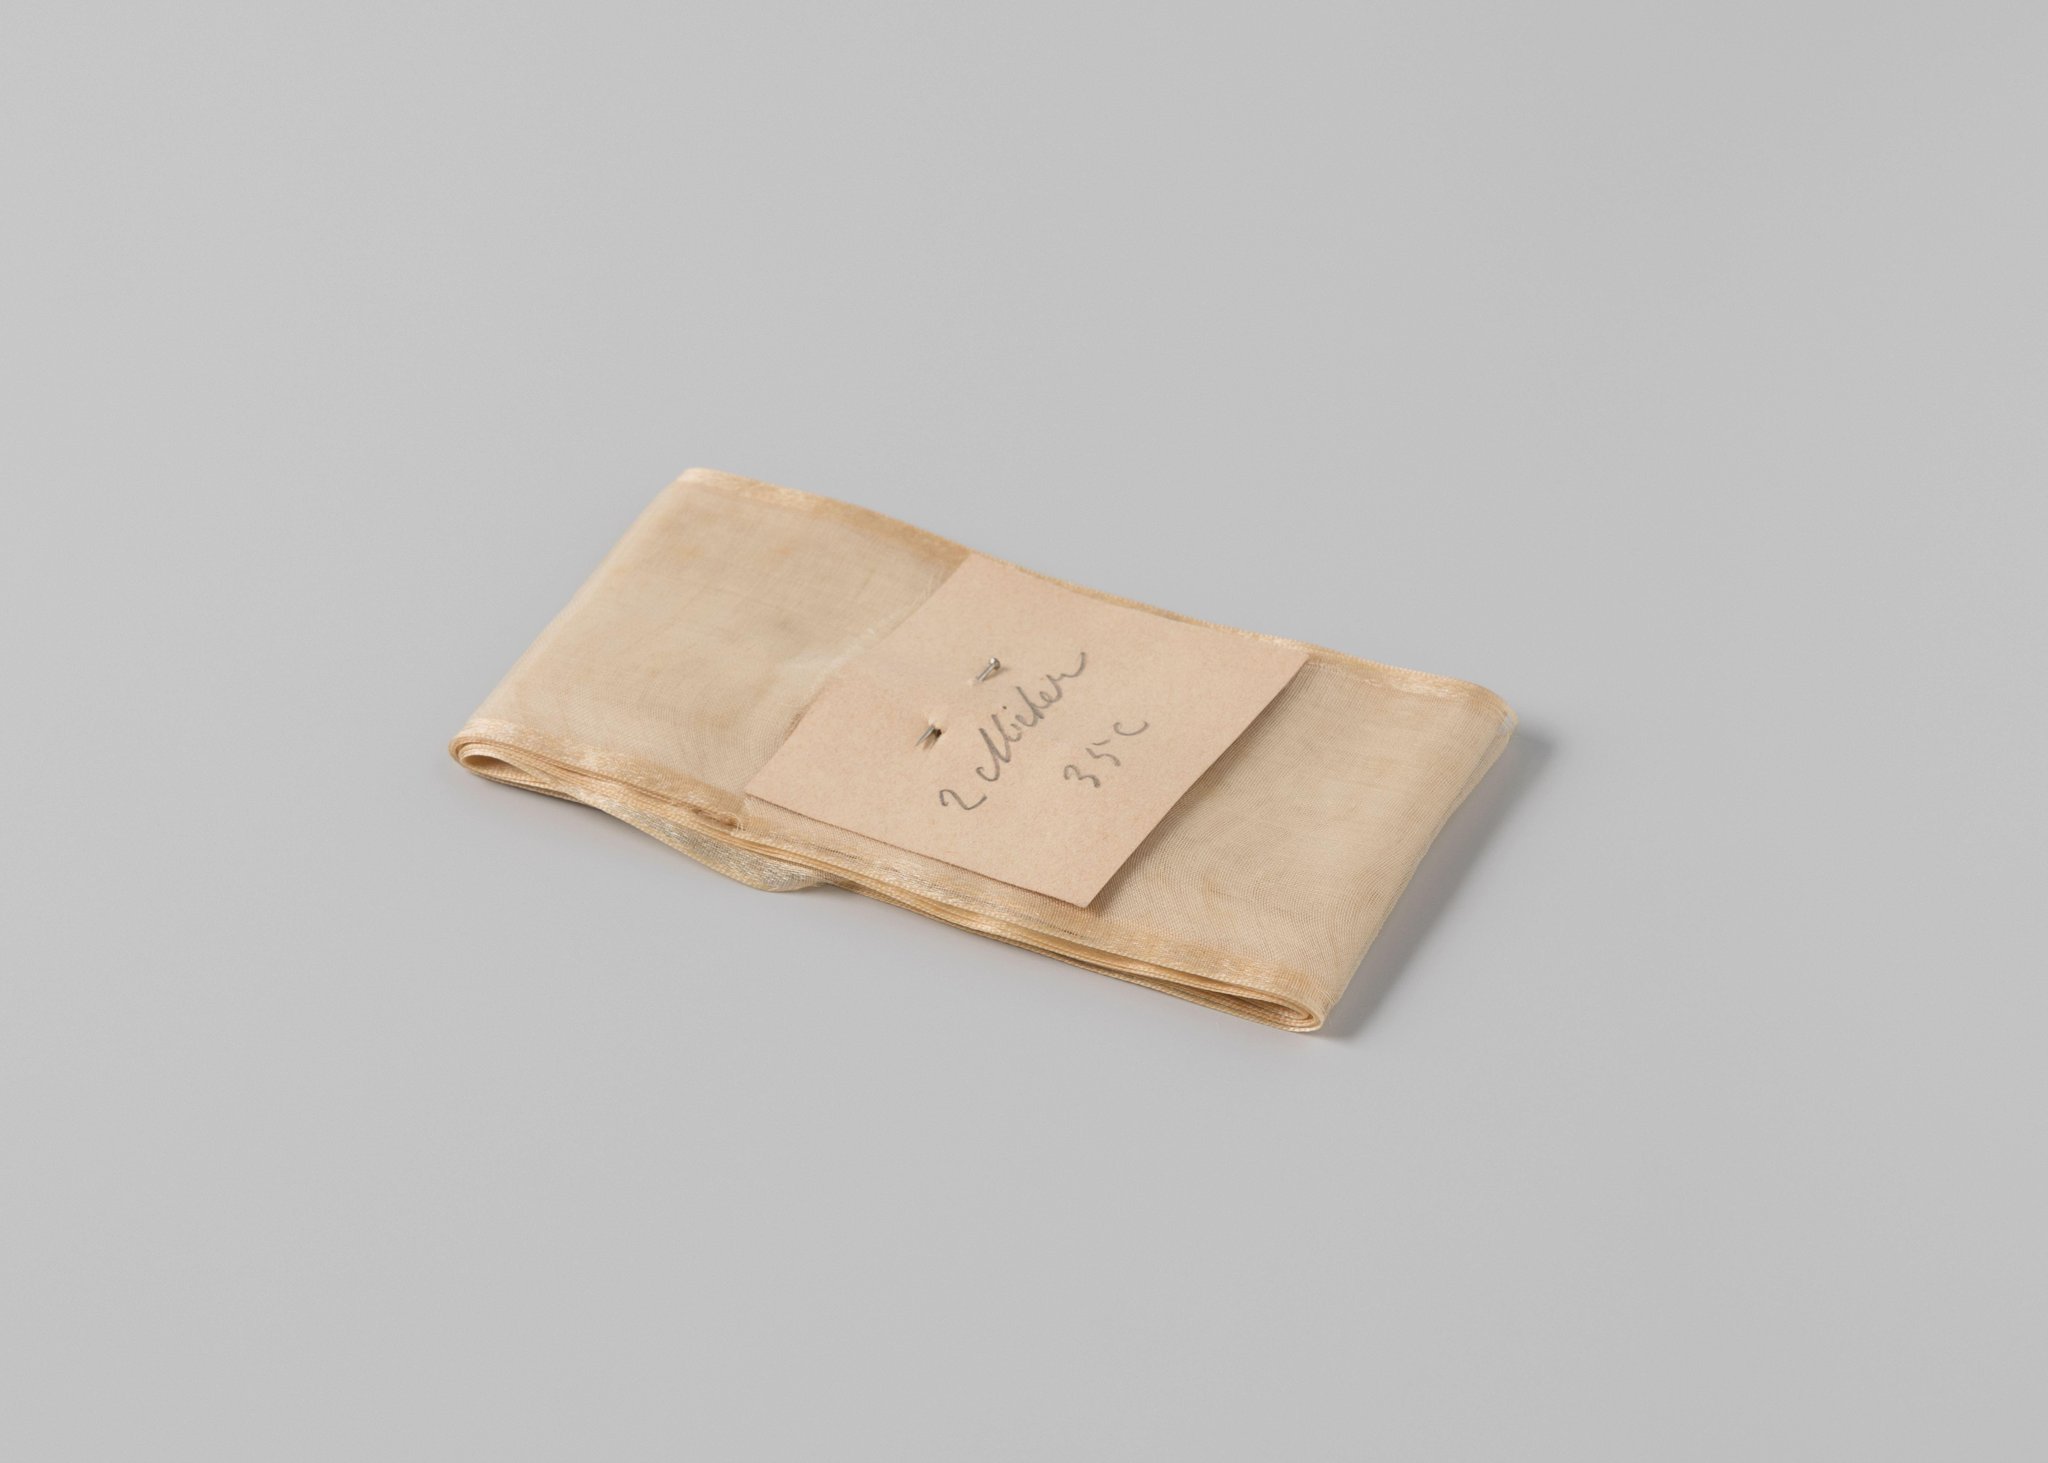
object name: ribbon material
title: Lint van crèmekleurig gaas van 2 meter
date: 1900-1915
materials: textile, silk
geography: nijmegen